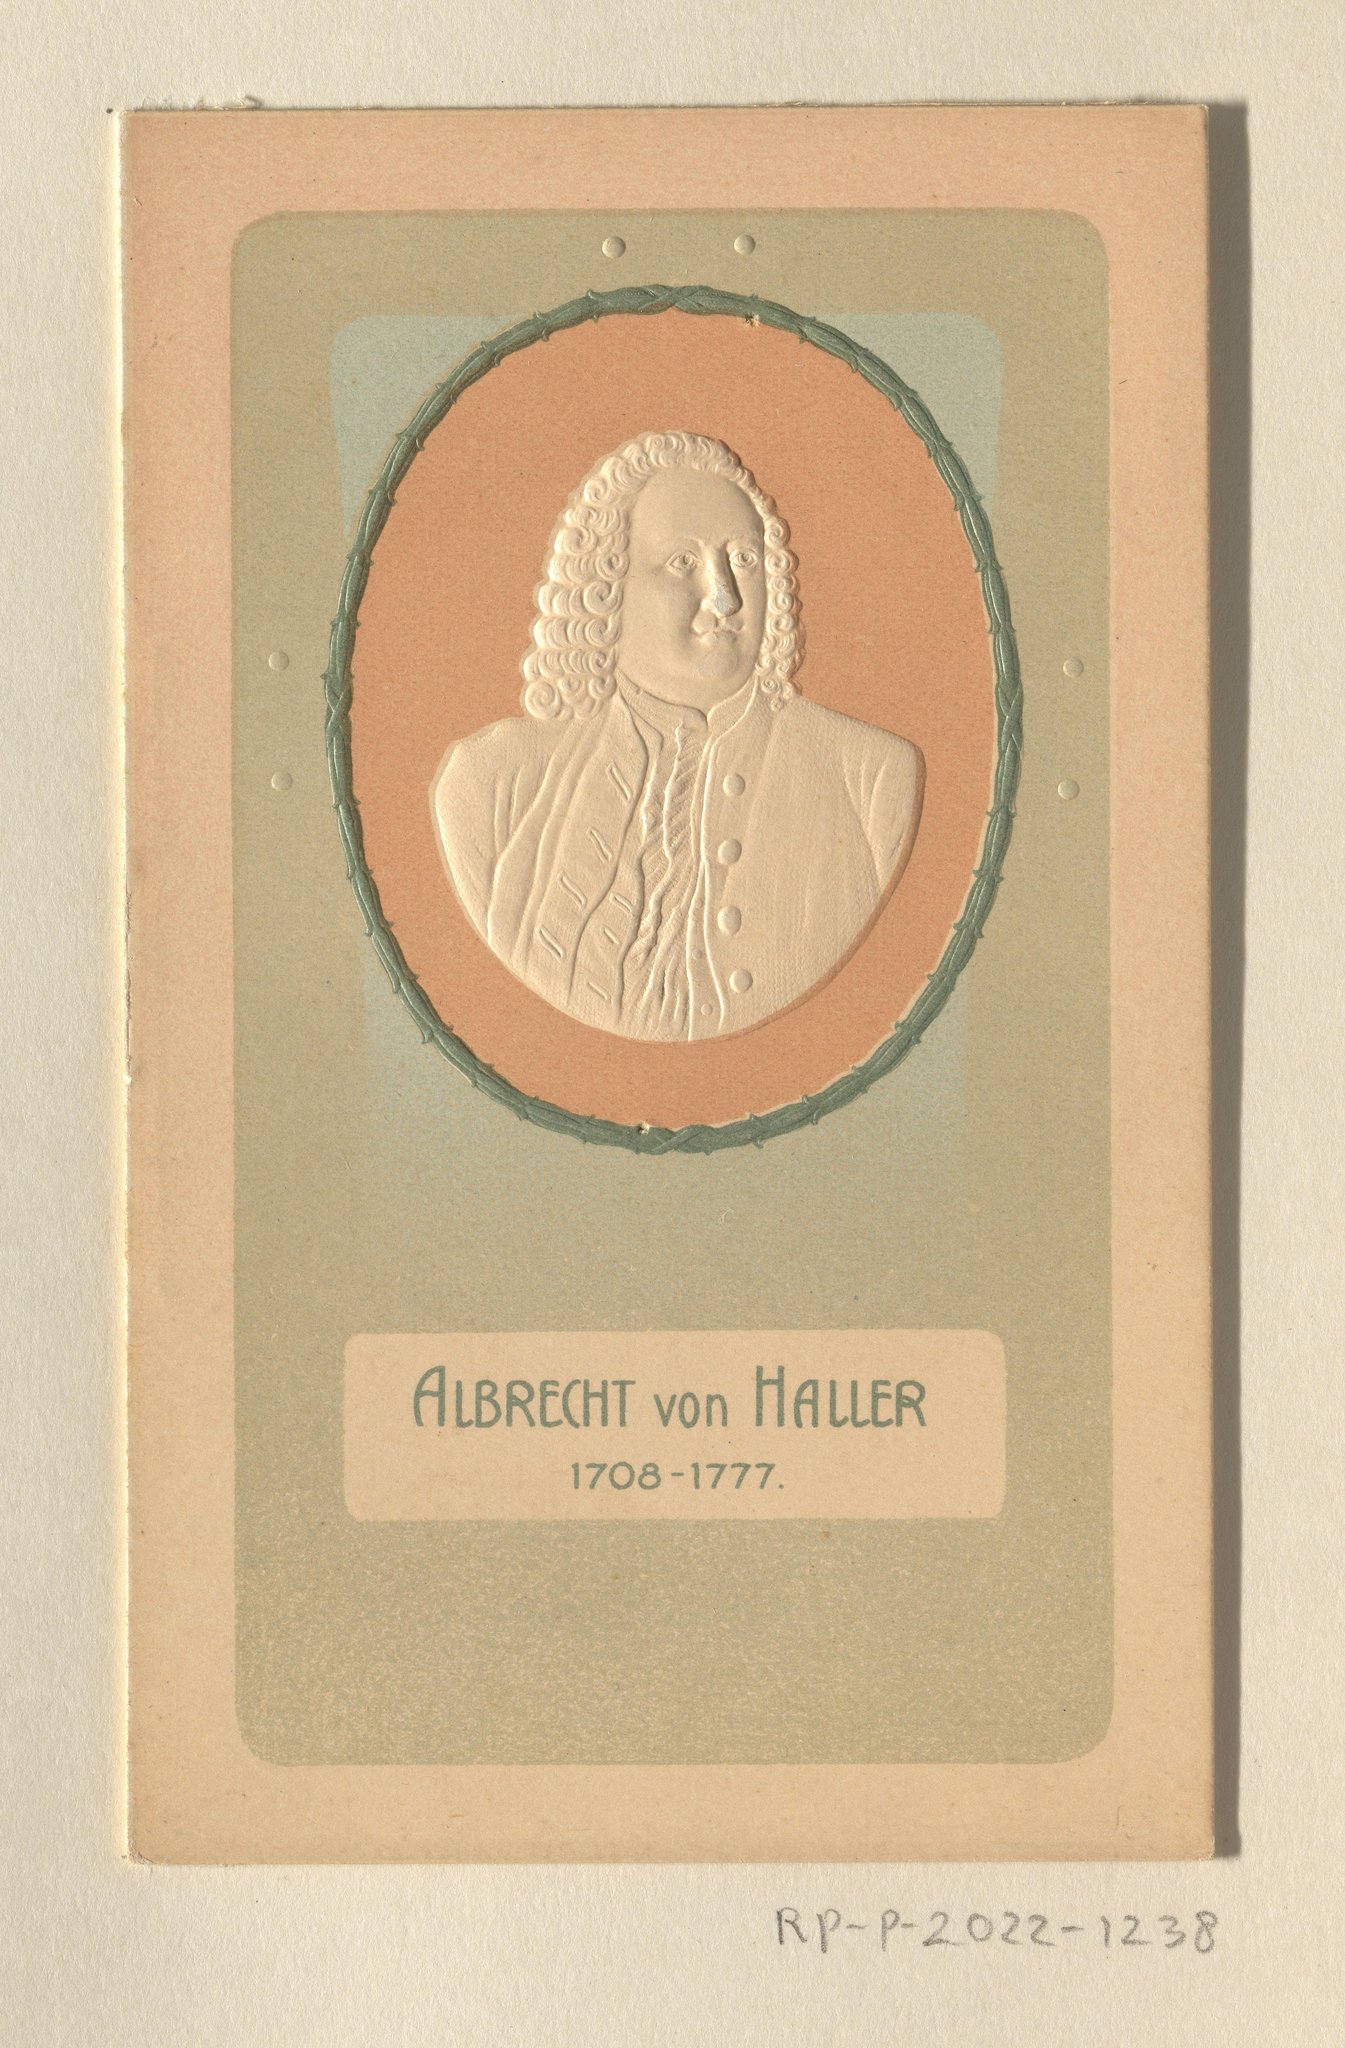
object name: print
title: Galerie berühmter Ärzte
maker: Anonymous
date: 1910-1915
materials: paper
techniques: blind stamped, lithograph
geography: germany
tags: advertising, physician, doctor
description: Kaart met portretbuste van de arts Albrecht von Haller. Onderdeel van de serie kaarten in reliëfdruk uitgebracht als reclame voor de medische producten van Tropon-Werke, Mülheim am Rhein.